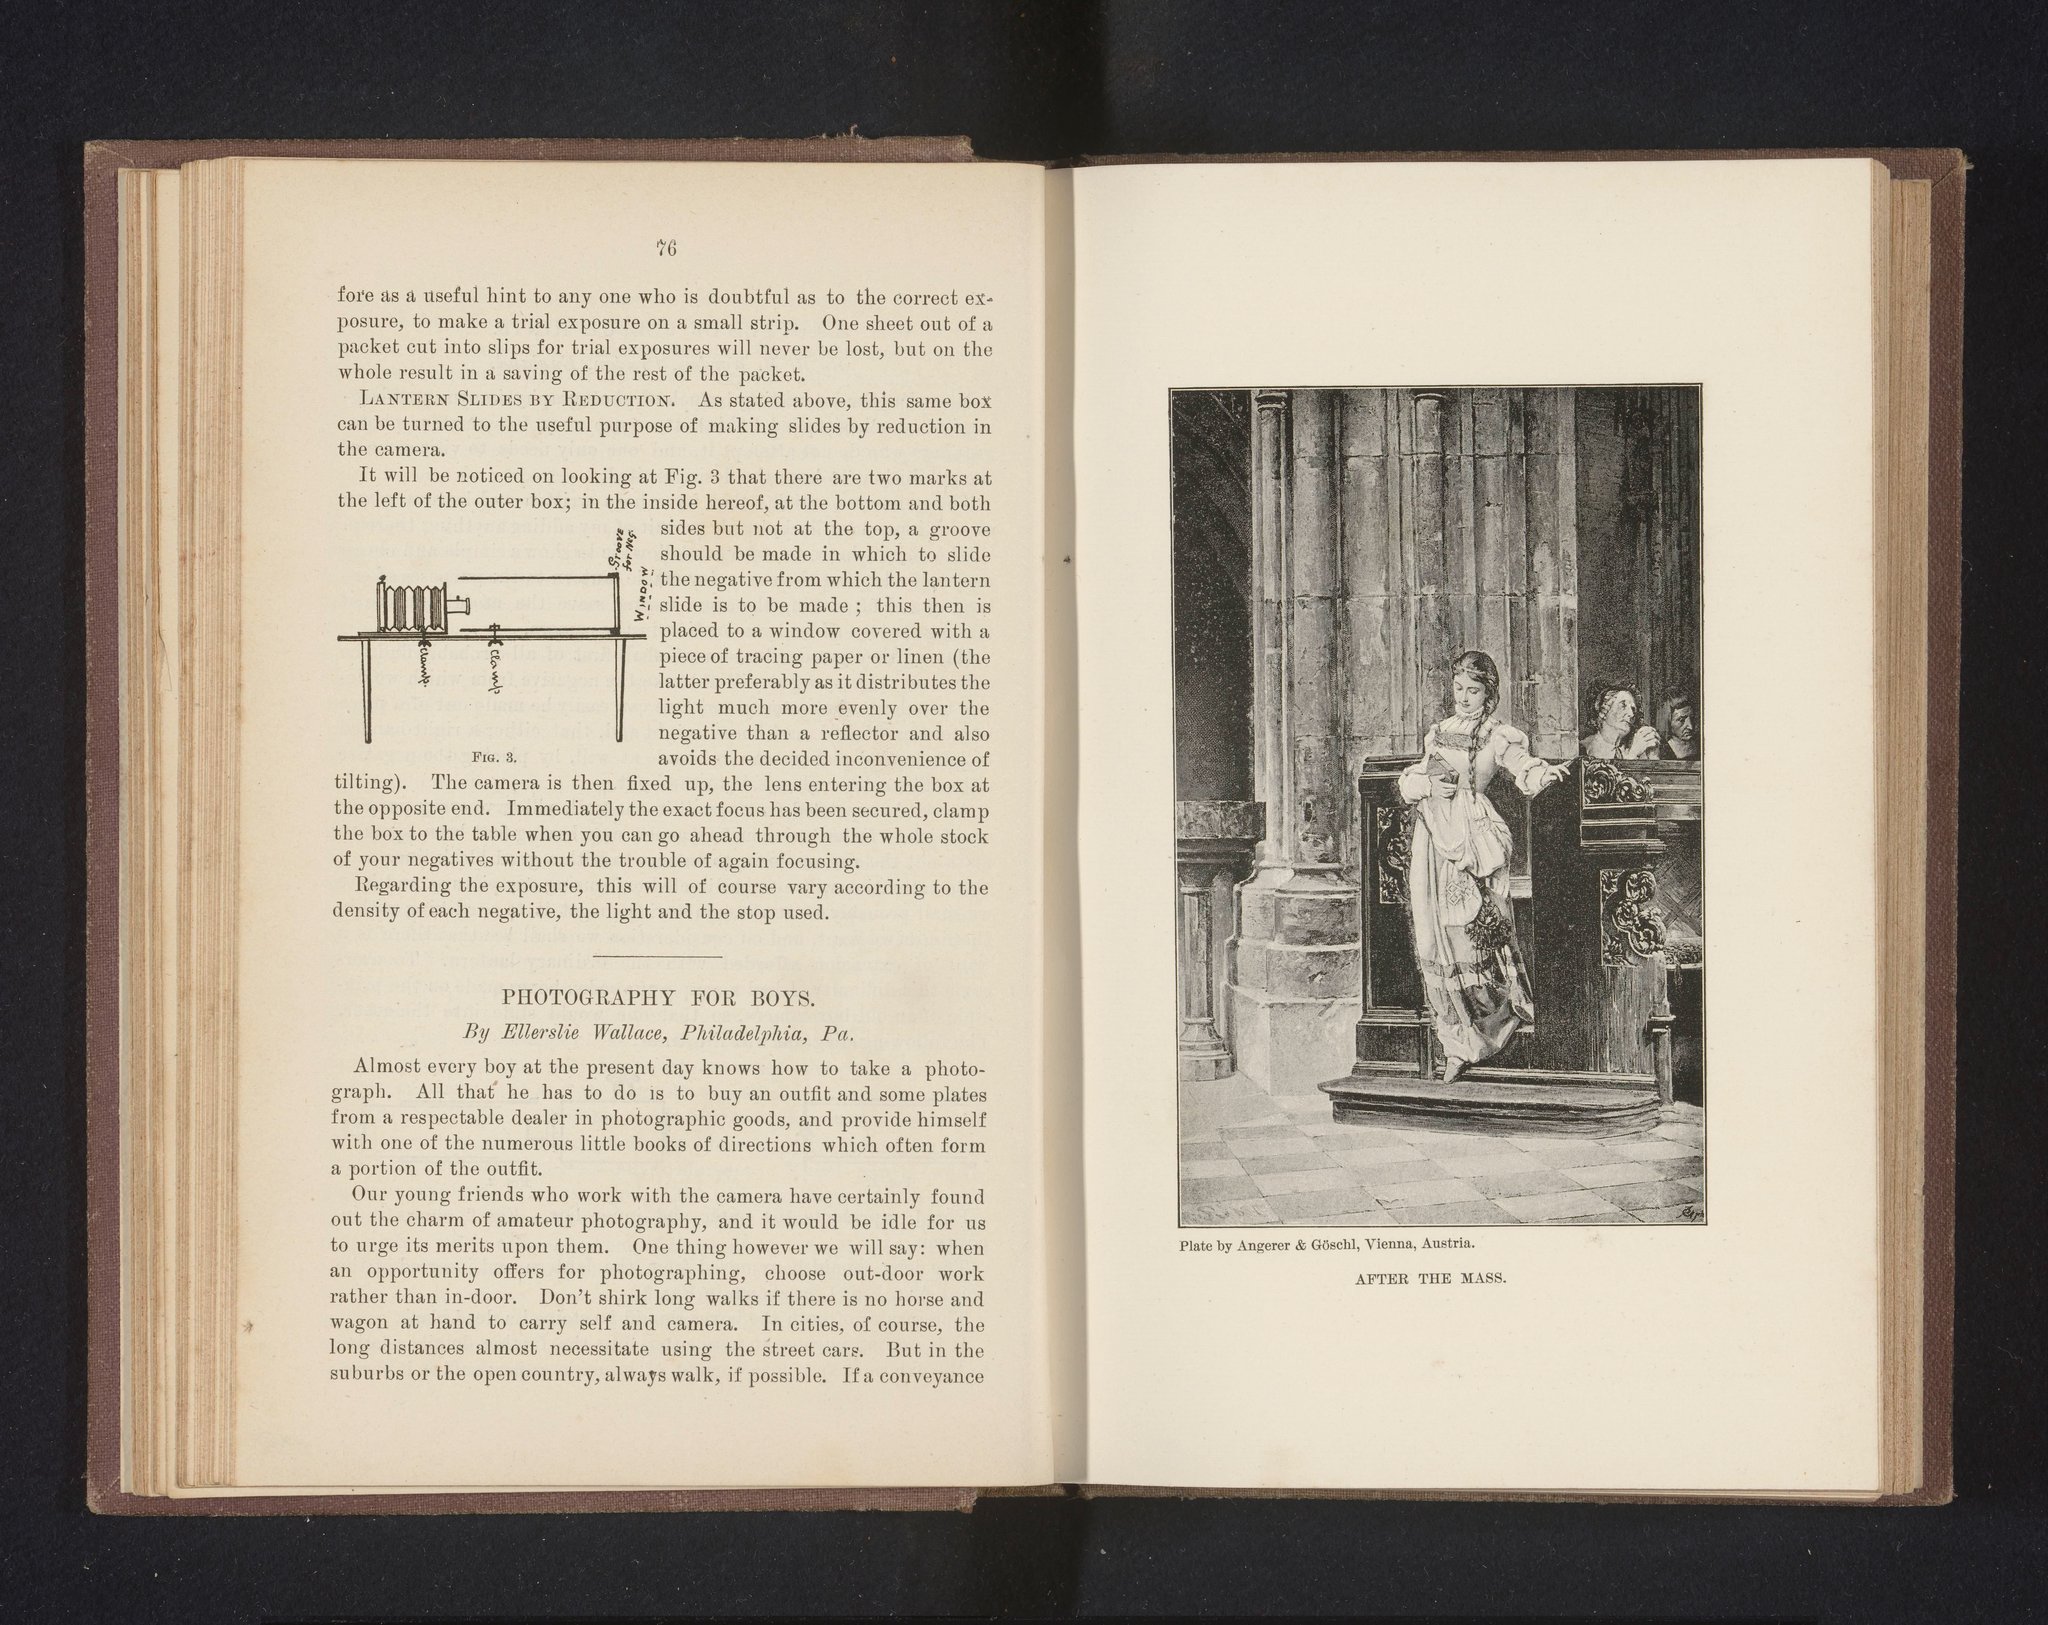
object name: reproduction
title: After the mass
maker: Anonymous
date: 1888-1893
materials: paper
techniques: autotype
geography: vienna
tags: adult woman, holy mass (divine service, especially of roman catholic church)